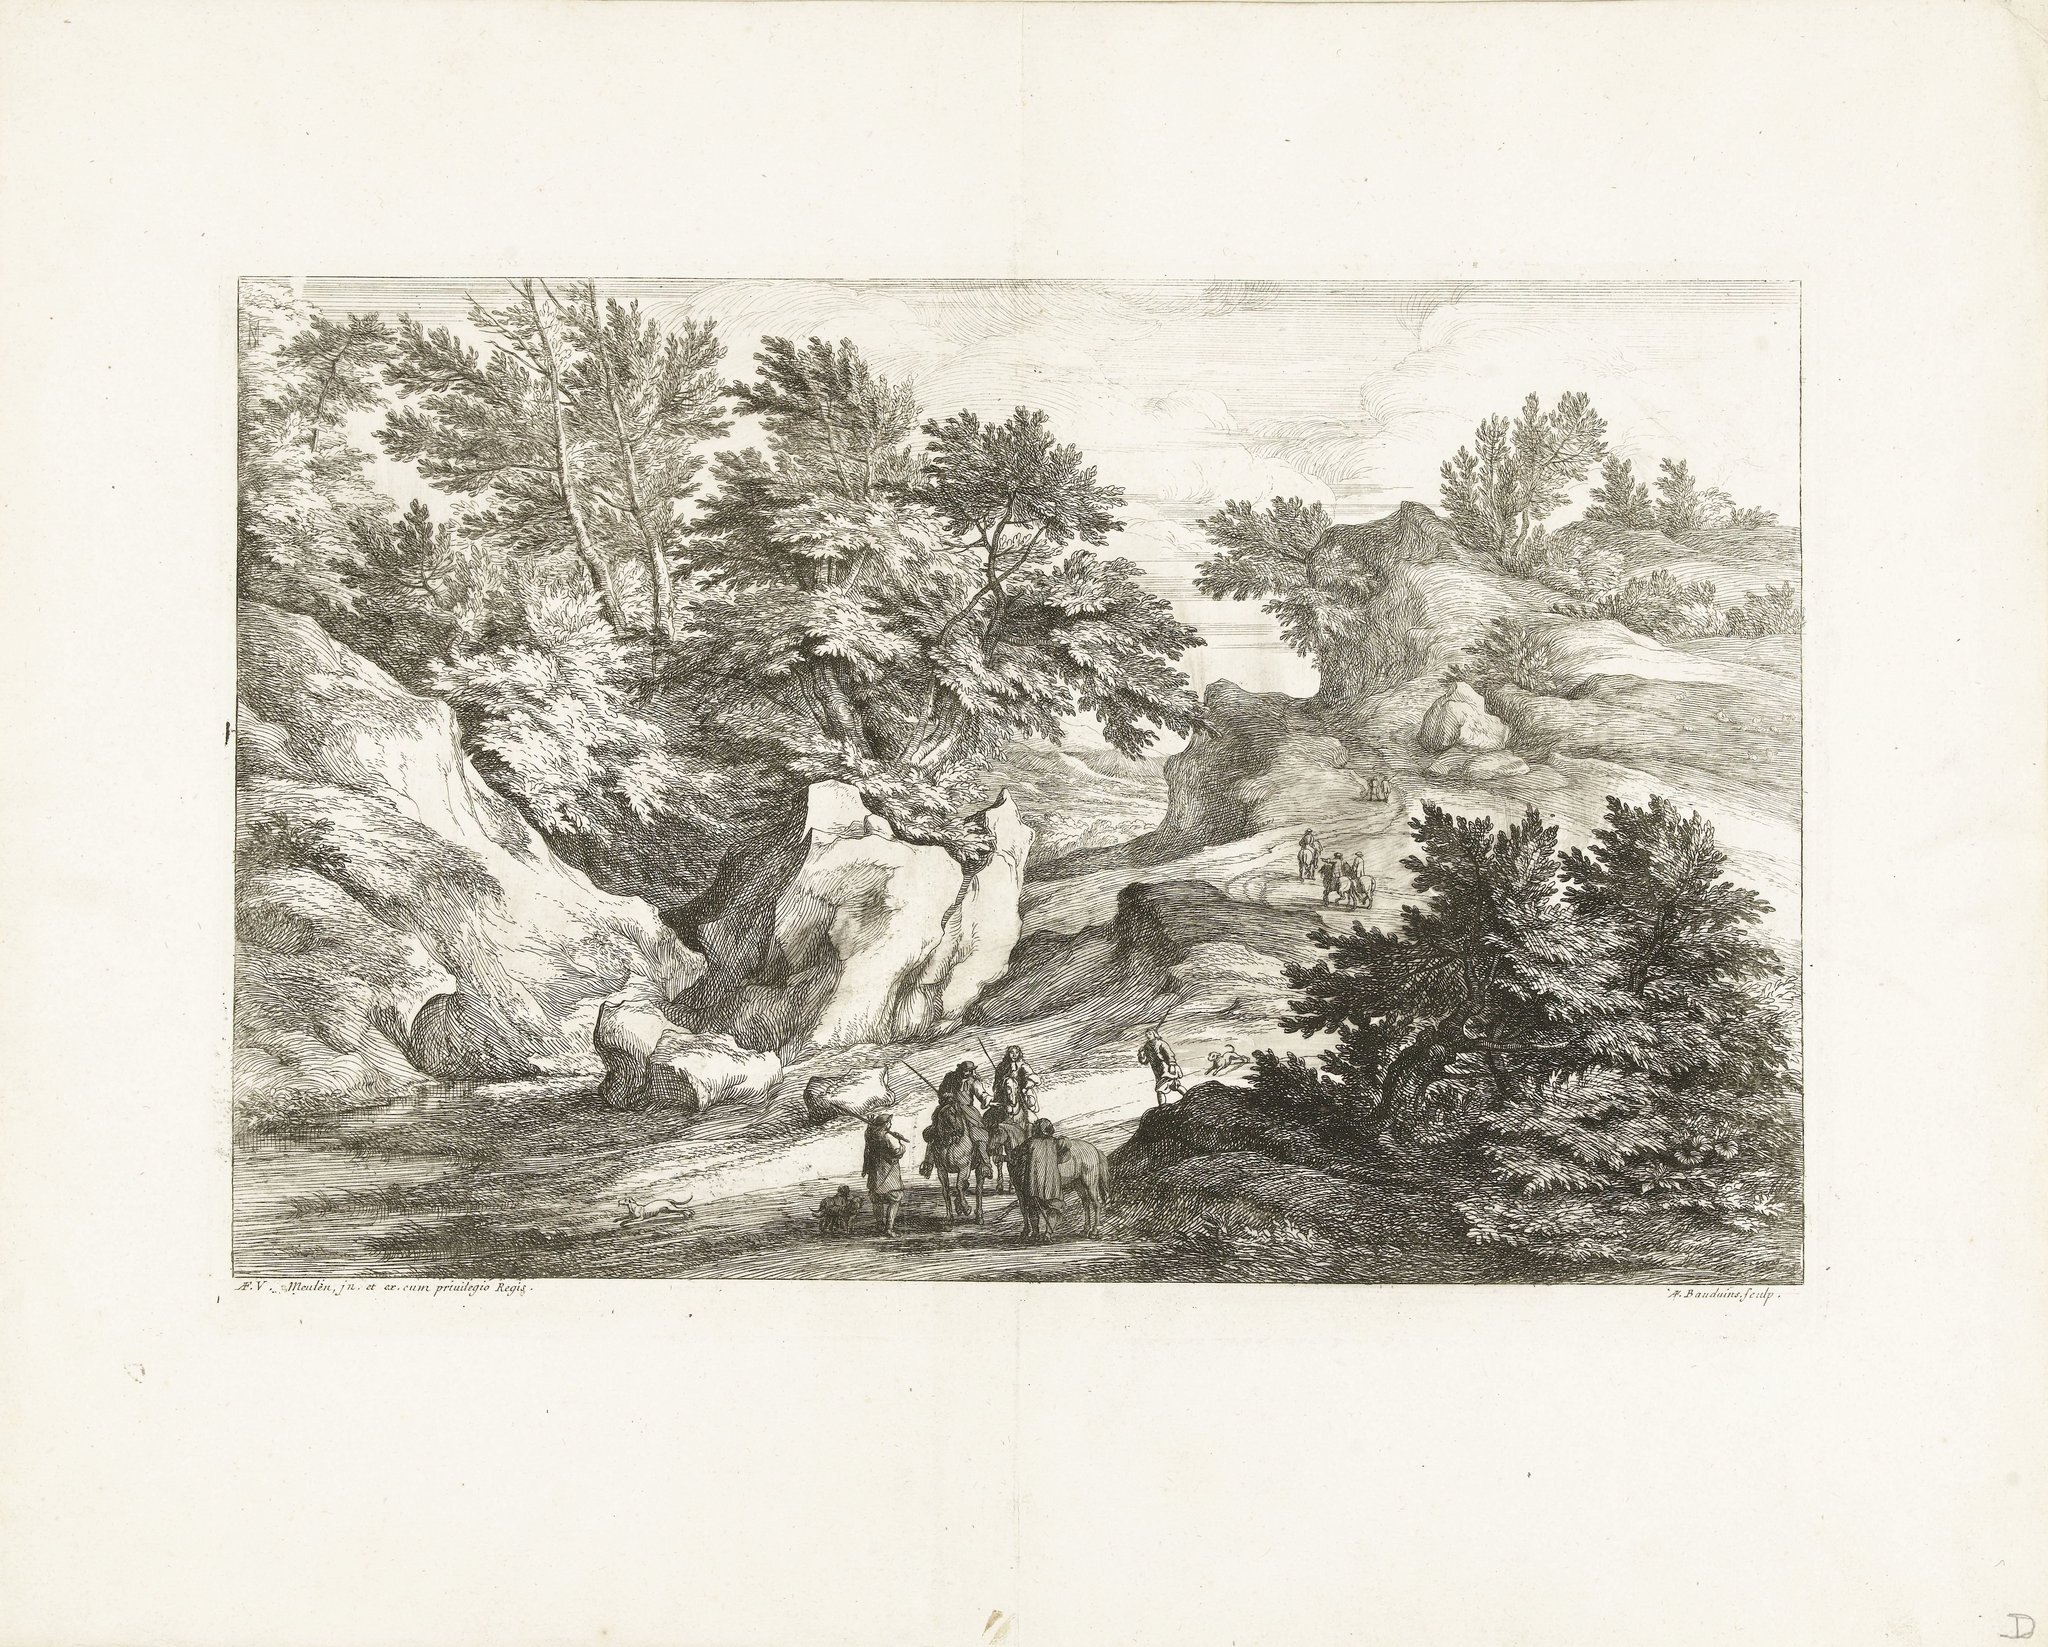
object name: print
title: Landschap met twee ruiters die de weg vragen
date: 1666-1674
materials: paper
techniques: etching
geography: paris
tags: 'en route', traveller under way, rocks (+ landscape with figures, staffage)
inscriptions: collector's mark: Lugt 2228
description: Heuvelachtig landschap met reizigers. Twee ruiters vragen de weg aan een paar jagers.